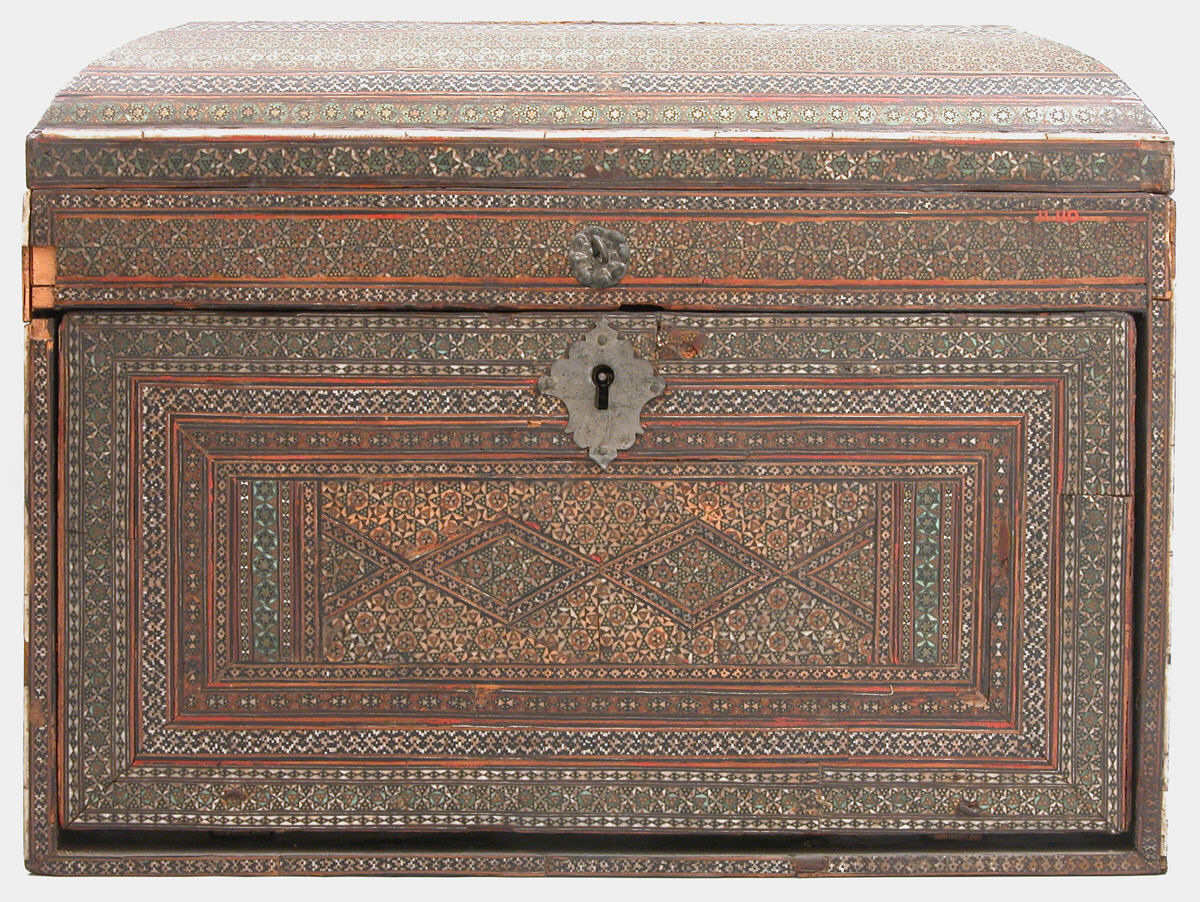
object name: box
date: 1801-1900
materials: wood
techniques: inlay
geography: iran